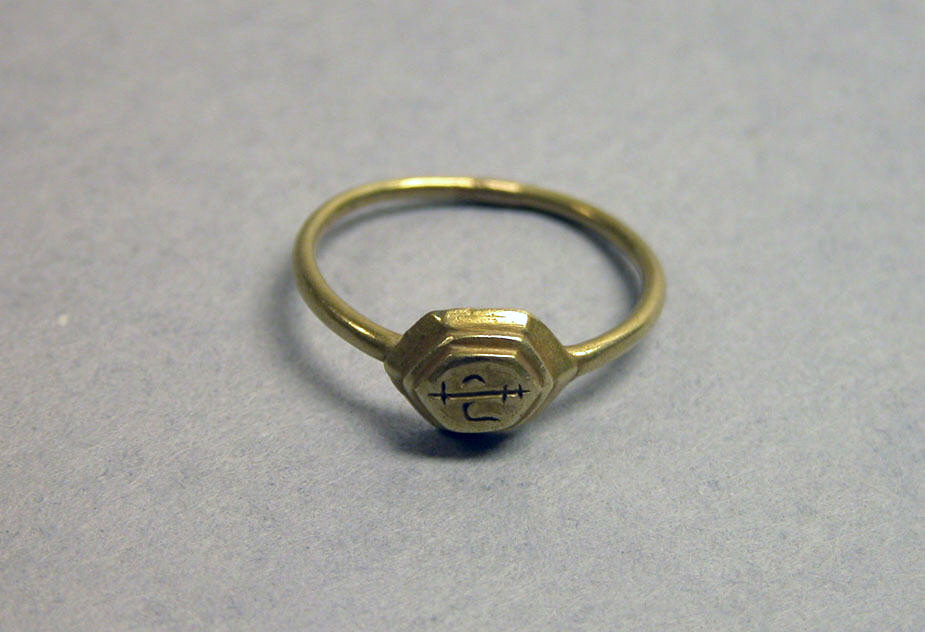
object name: ring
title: Ring with Hexagonal Bezel and "Sri" Inscription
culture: indonesian, javanese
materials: gold